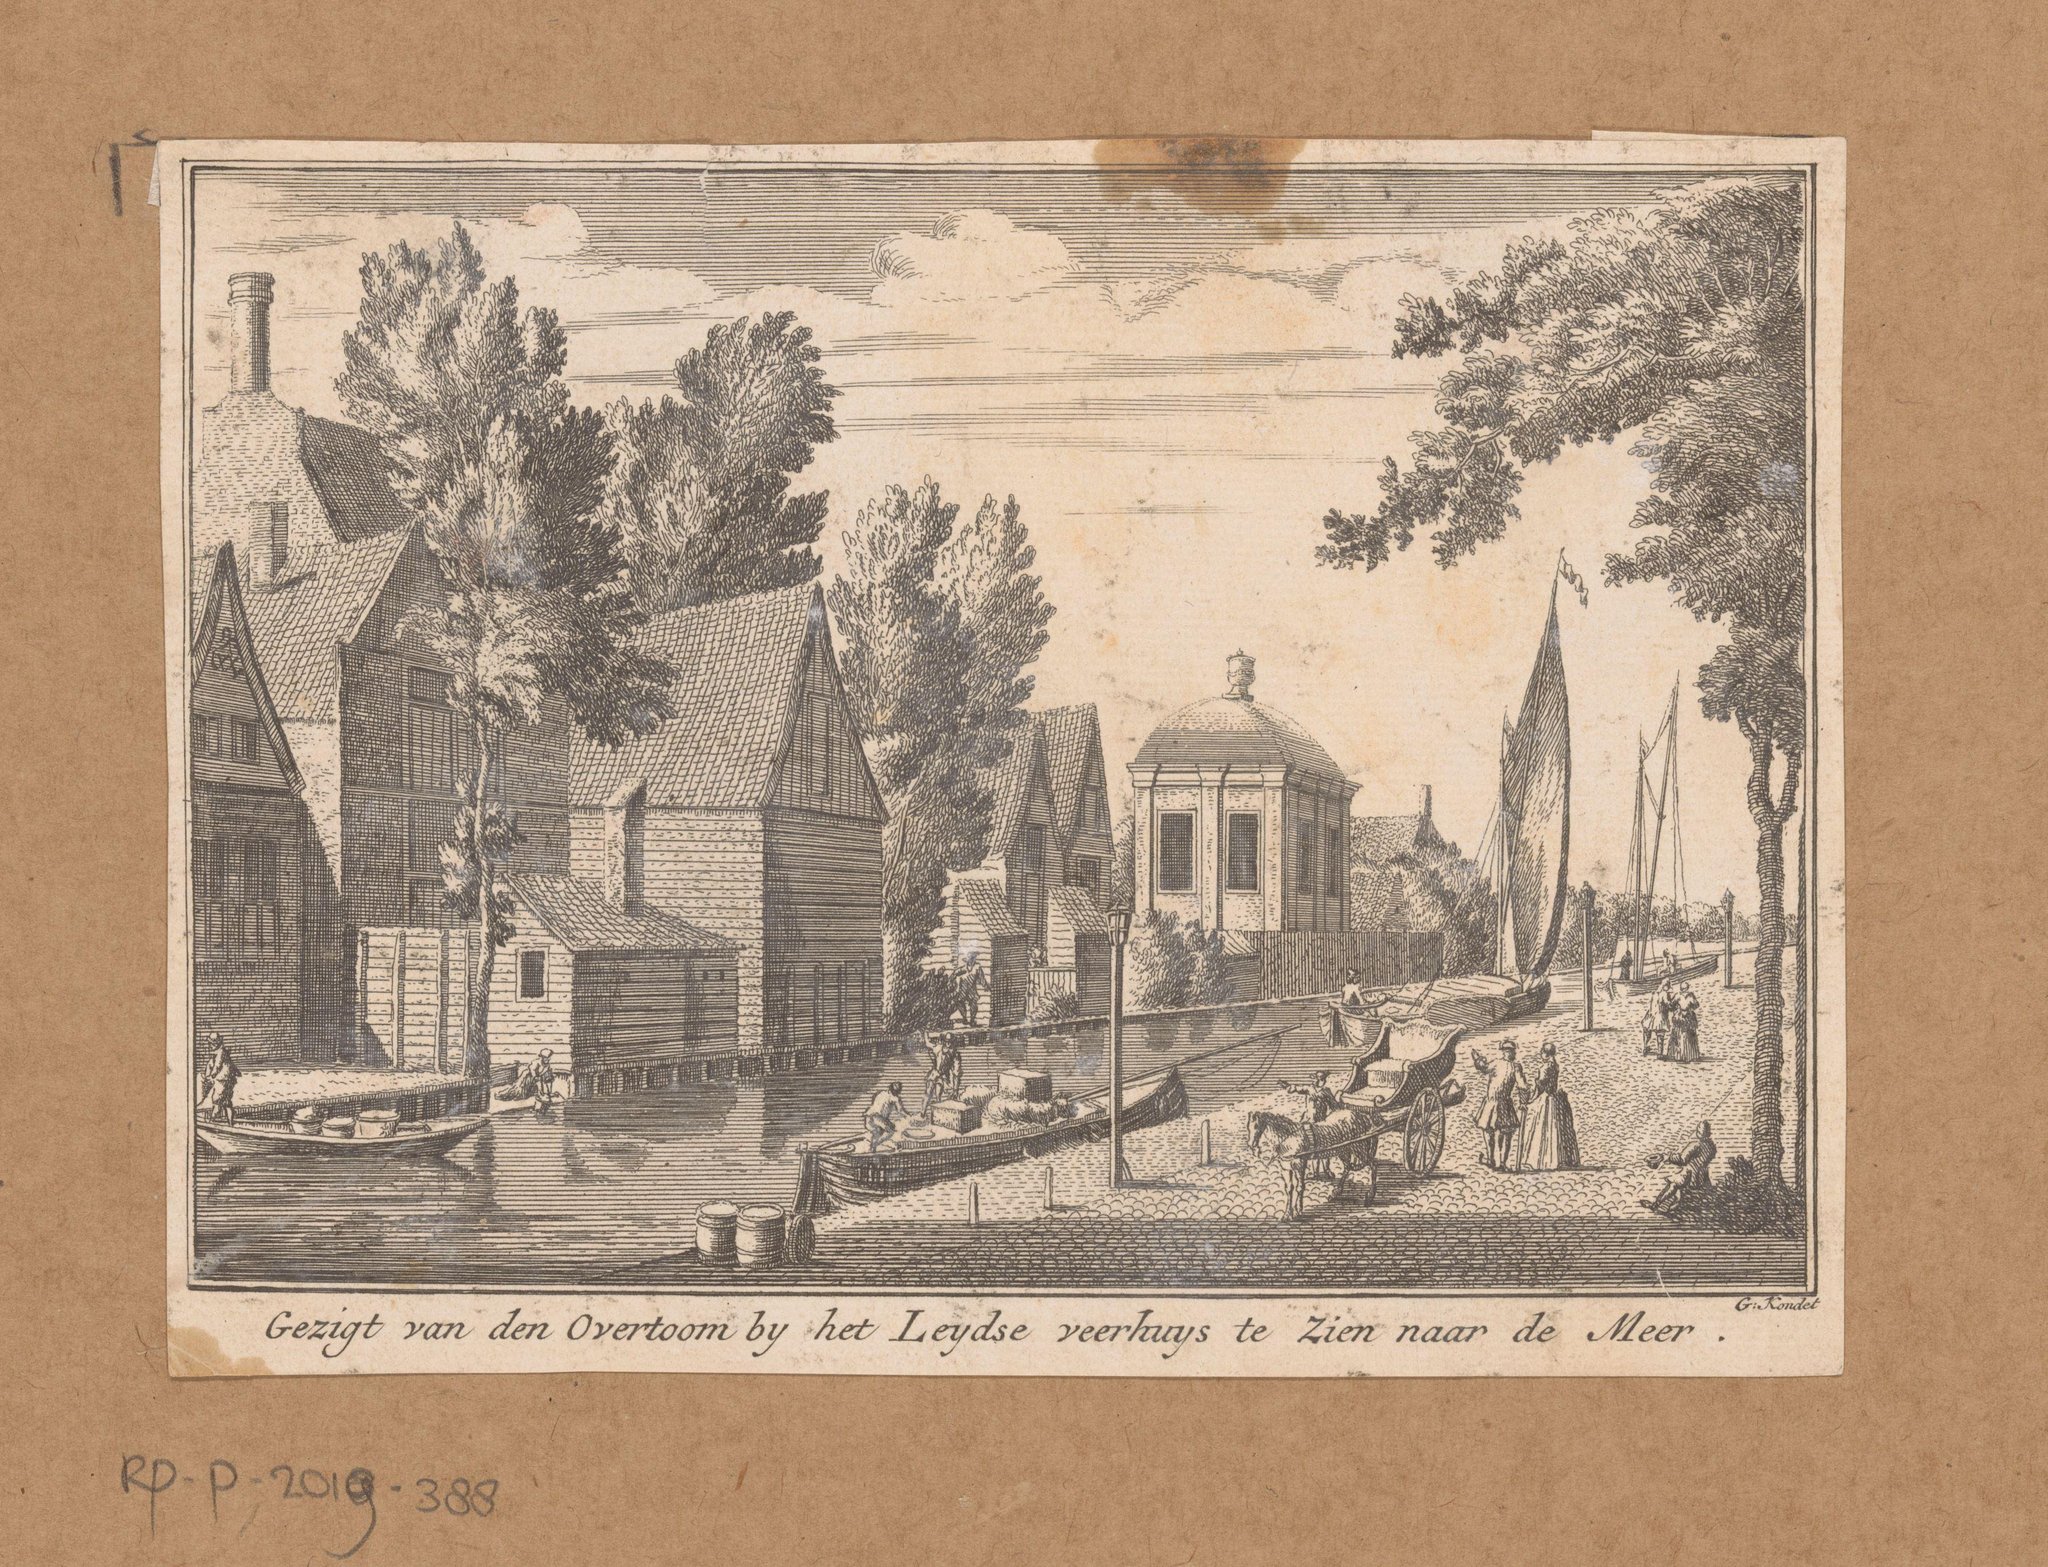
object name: print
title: Gezicht vanaf het eind van de Overtoom bij het Leidse veerhuis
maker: gerardus condet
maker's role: print maker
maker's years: 1715-1764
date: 1725-1764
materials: paper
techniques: etching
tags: sailing-ship, sailing-boat, rowing-boat, canoe, etc., canals, waters (in city), two-wheeled vehicle drawn by one animal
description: Schinkel, gezien in zuidelijke richting, vanaf het eind van de Overtoom bij het Leidse Veerhuis. Links de achterzijde van de eerste huizen aan de Amstelveenseweg ter hoogte van de huidige Schinkelhavenstraat. Rechts de Sloterkade.